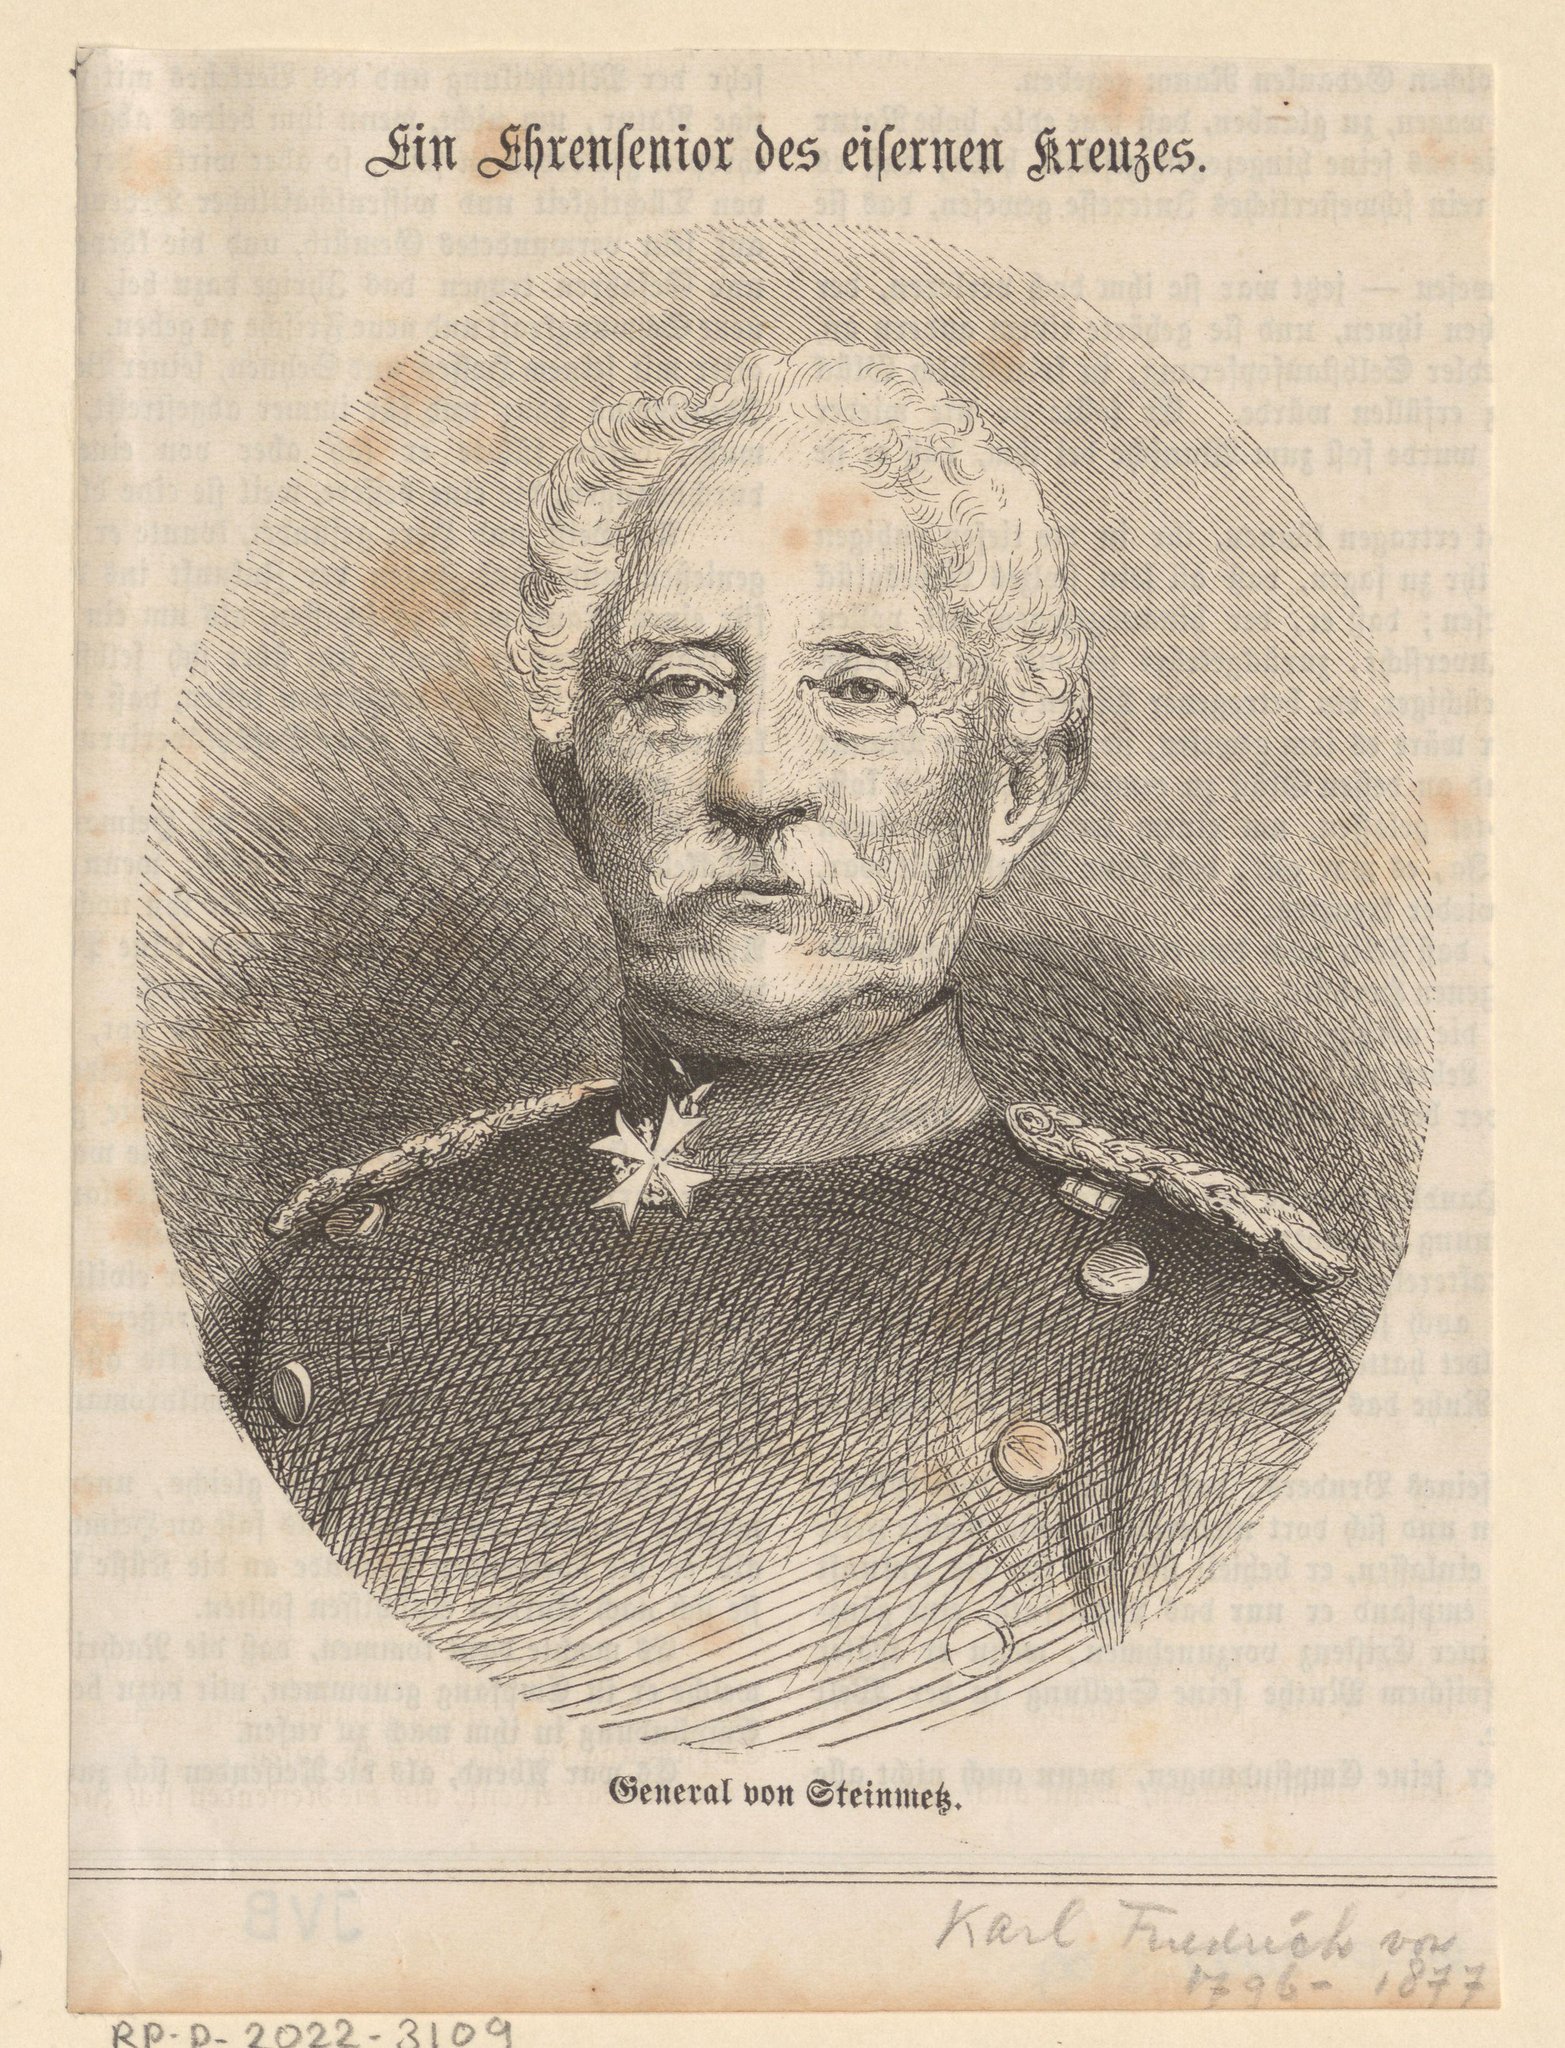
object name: print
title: Portret van Karl Friedrich von Steinmetz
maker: Anonymous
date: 1854-1899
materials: paper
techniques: letterpress printing, engraving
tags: poland, commander-in-chief, general, marshal, historical persons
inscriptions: stamp: ‘JVB’